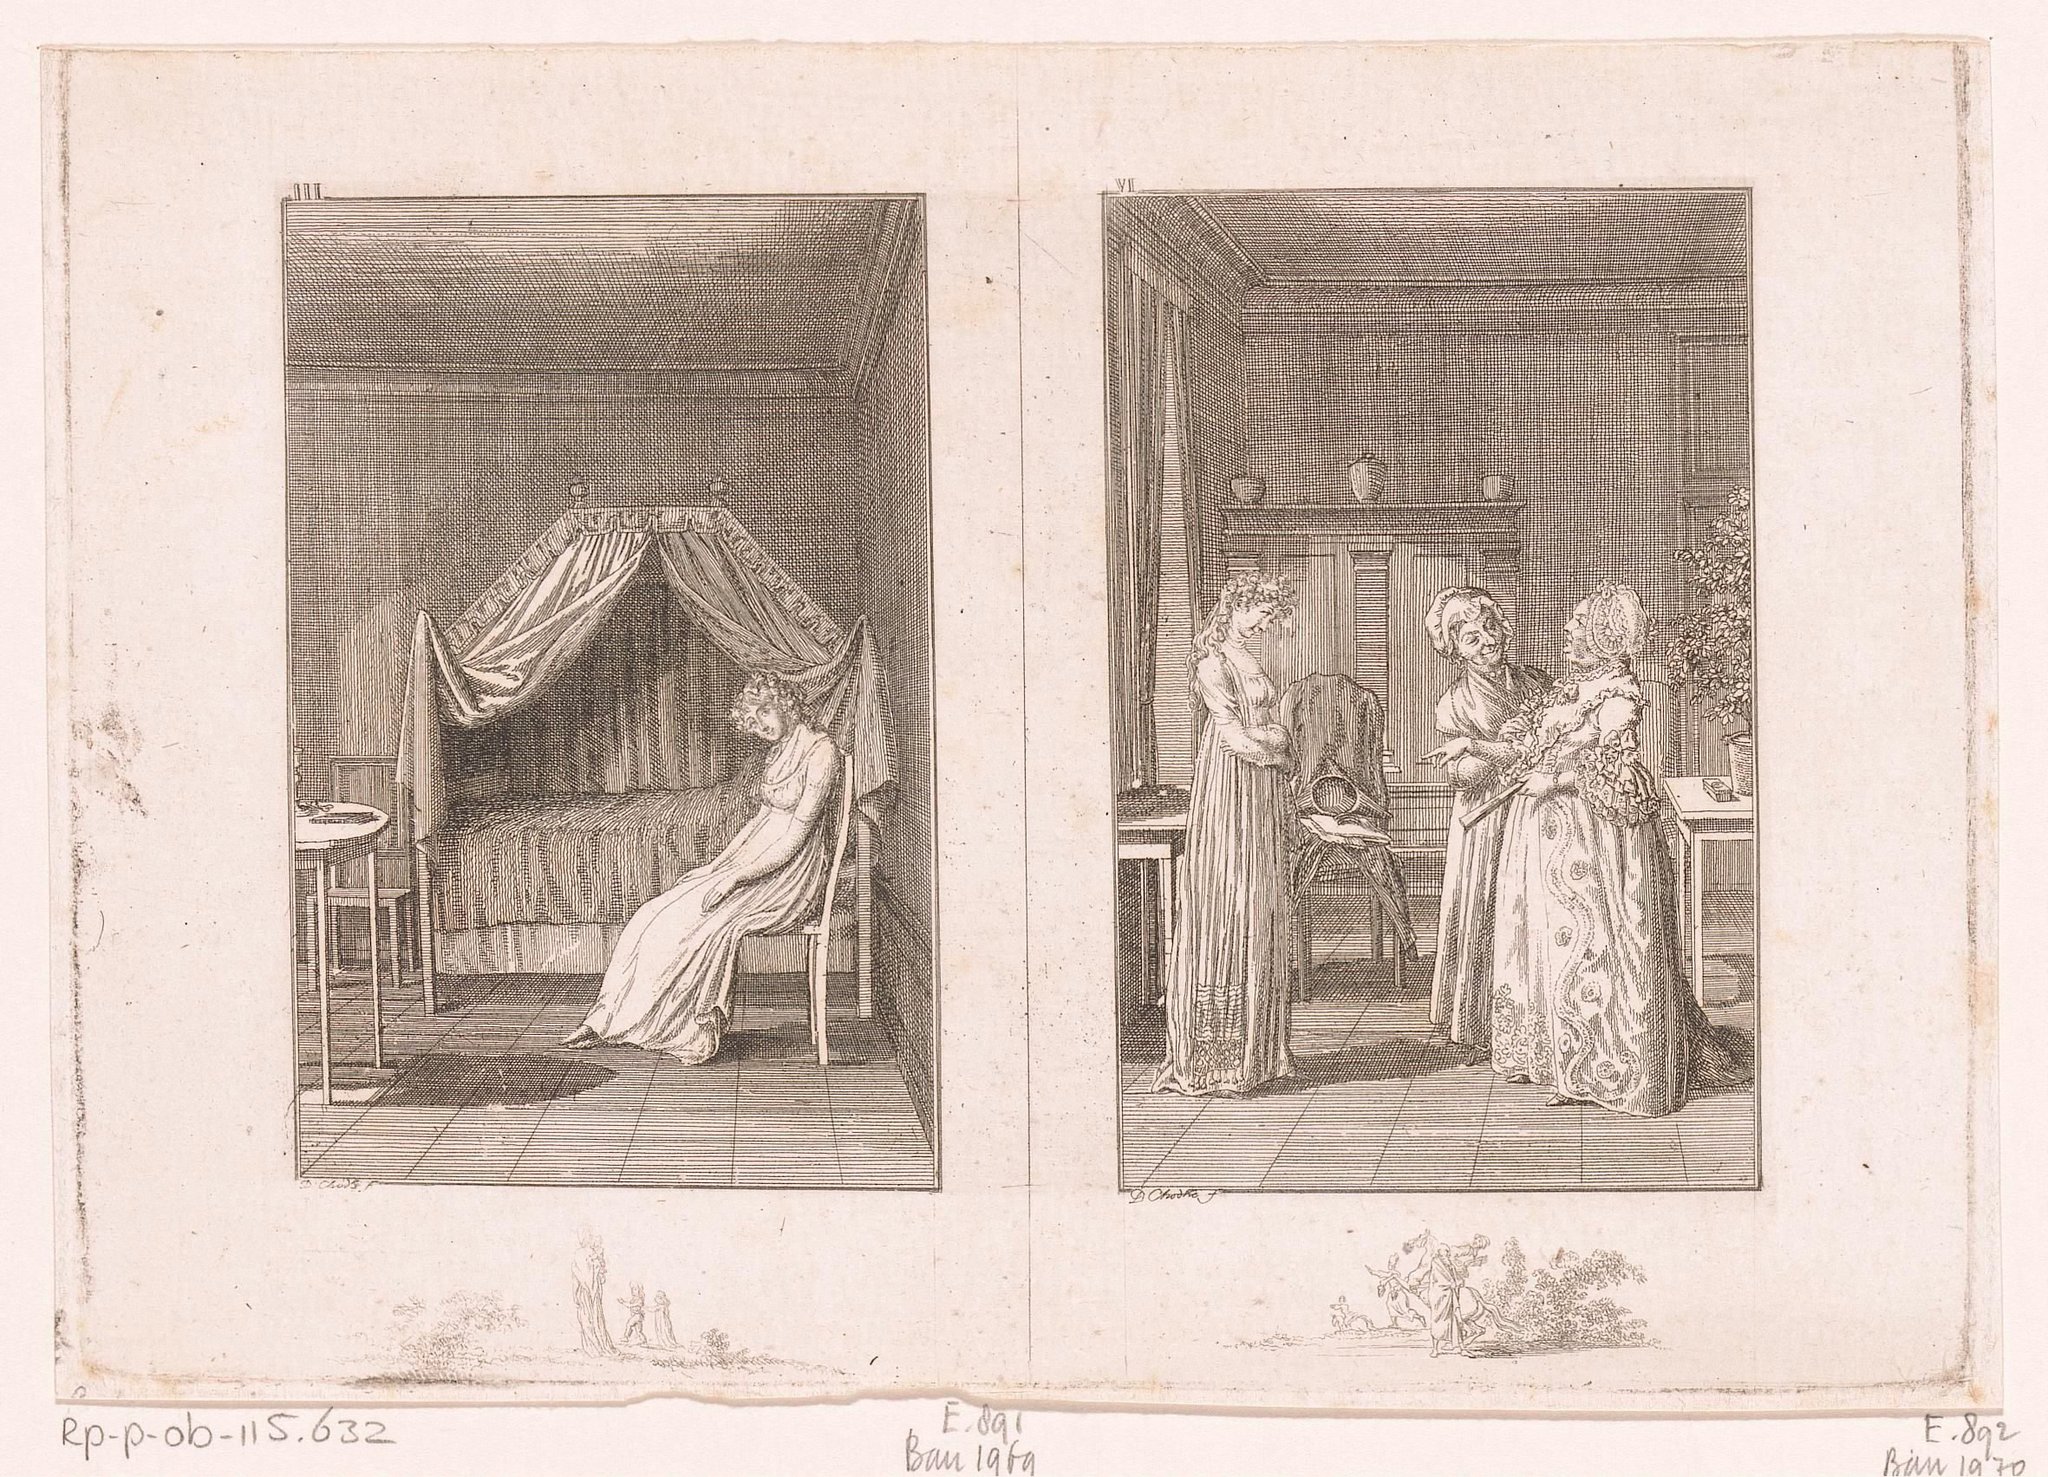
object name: print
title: Twee voorstellingen uit de verhalen van Wilhelm Gottlieb Becker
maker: daniel nikolaus chodowiecki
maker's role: draughtsman, print maker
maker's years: 1726-1801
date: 1799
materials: paper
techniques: etching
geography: berlin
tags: adolescent, young woman, maiden, conversation, dialogue; conversation piece, bedroom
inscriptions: collector's mark: Lugt 2228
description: Prent gebruikt voor: Becker, Wilhelm Gottlieb. Almanach und Taschenbuch zum geselligen Vergnügen (...). Leipzig: Johann Christian Friedrich Roch, [1800].